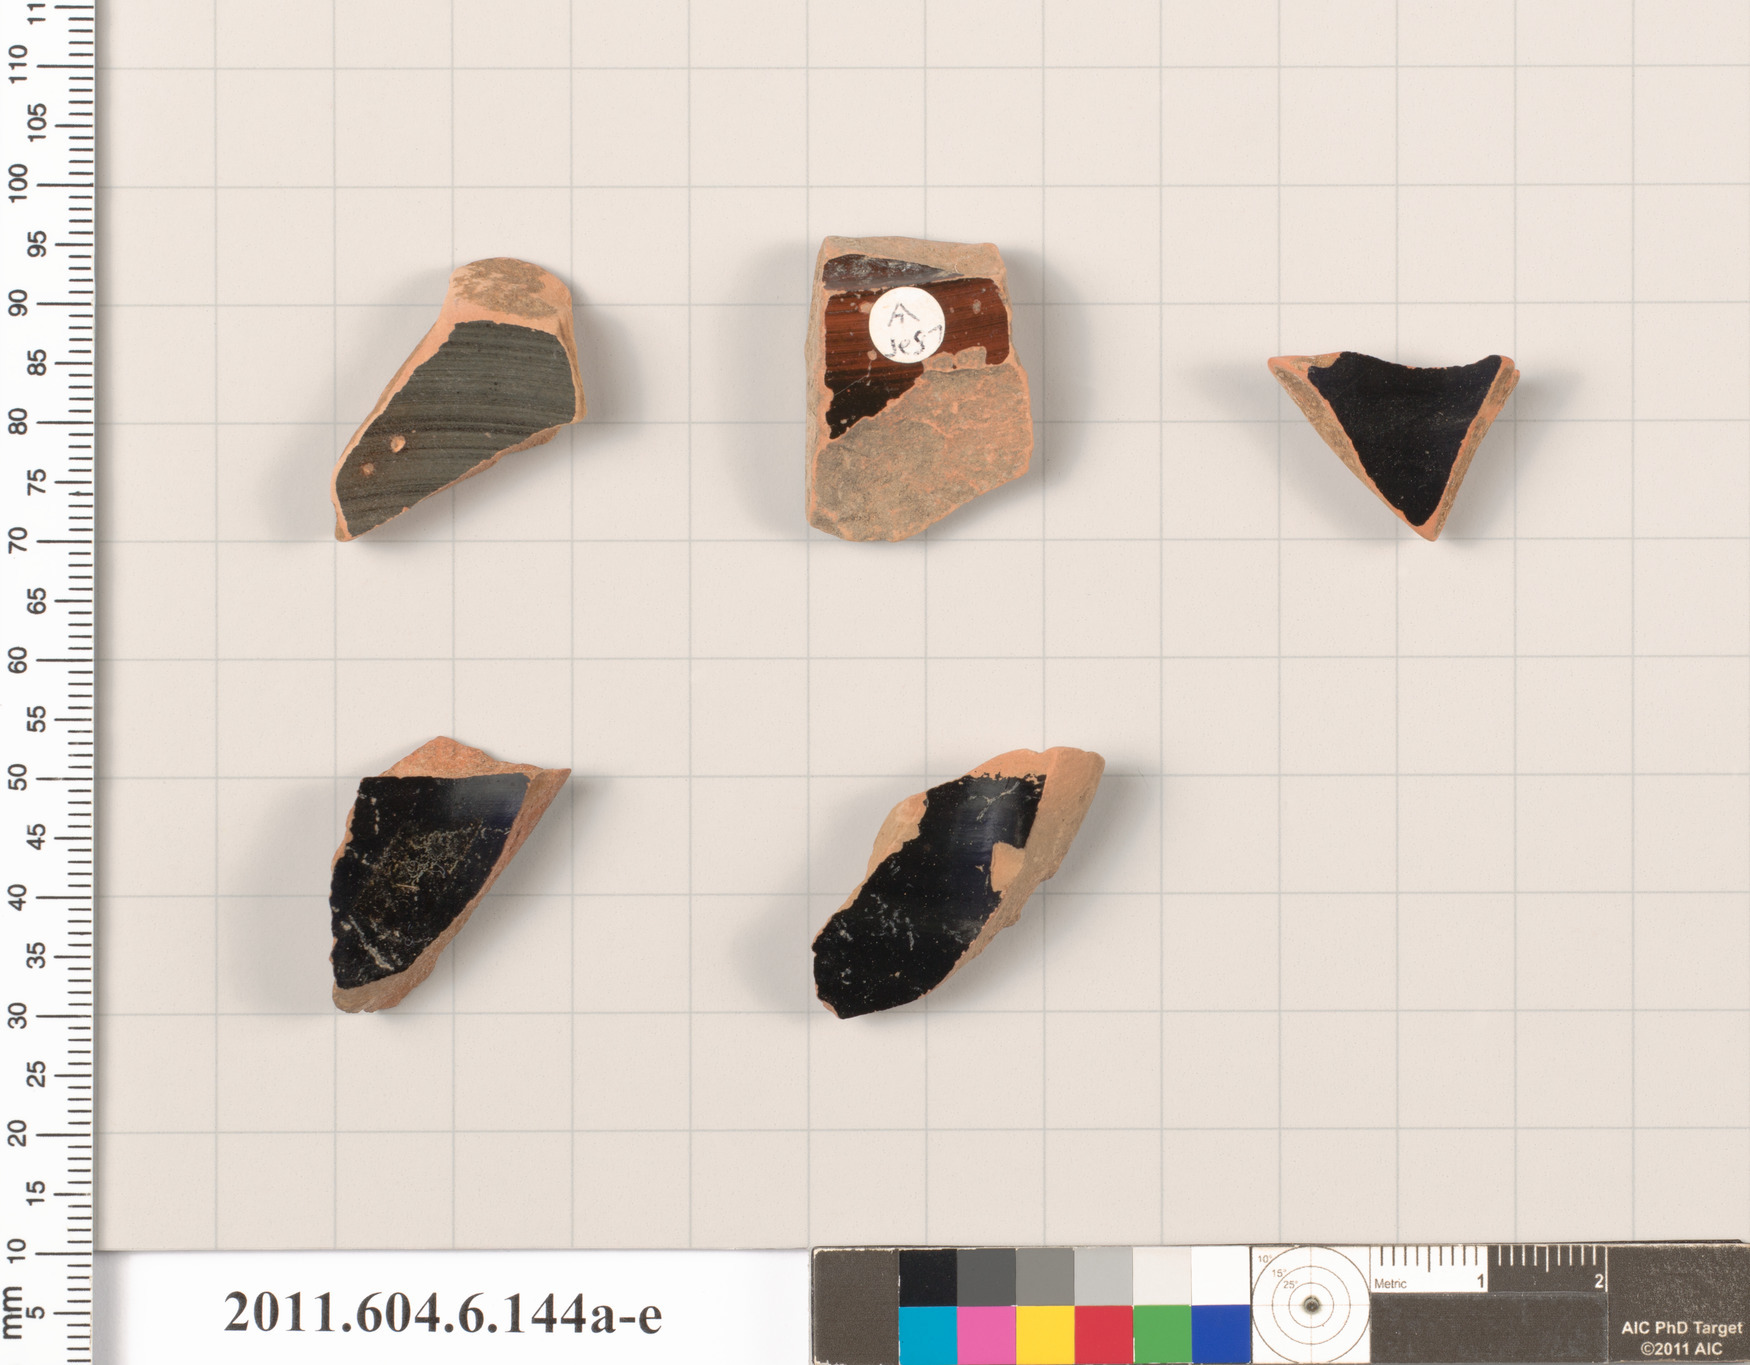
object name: undetermined open shape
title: Terracotta fragments of open shapes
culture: greek, attic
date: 600-401 BCE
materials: terracotta